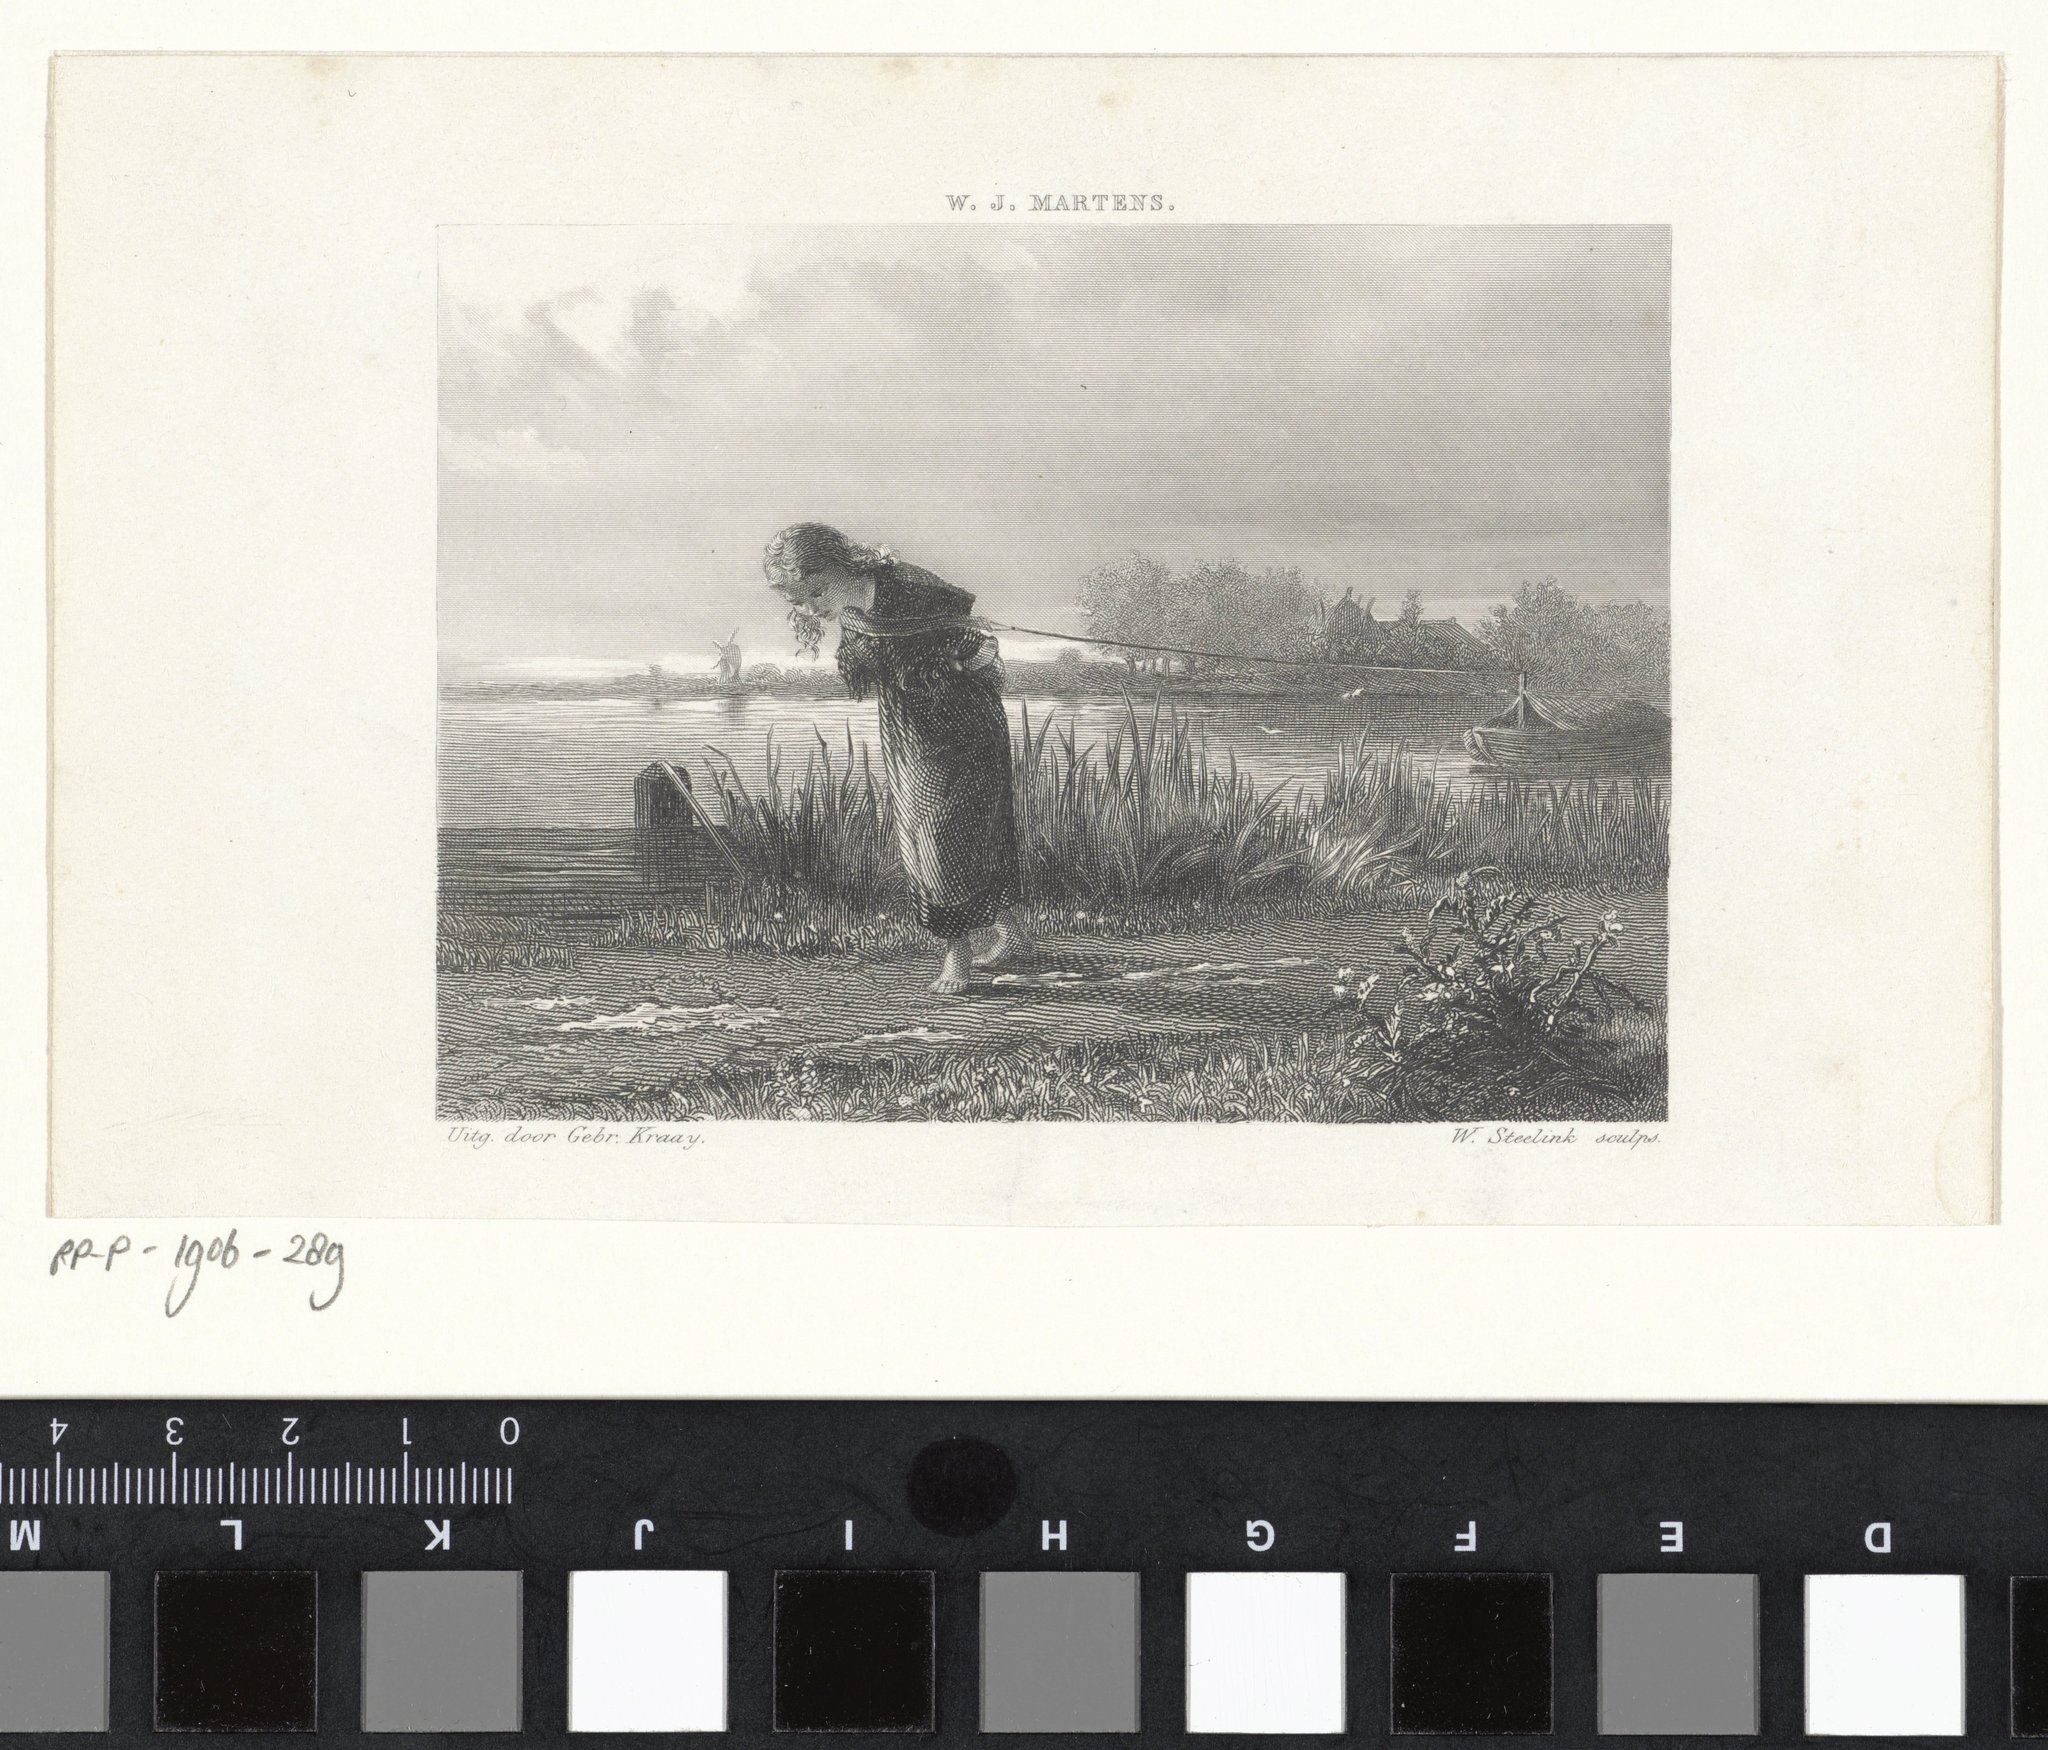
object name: print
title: Meisje trekt een schuit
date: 1867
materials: paper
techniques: etching, engraving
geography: amsterdam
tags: girl (child between toddler and youth), tow-boat, towing-barge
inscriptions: collector's mark: Lugt 2228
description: Illustratie voor: Castalia, jaarboekje aan de fraaie letteren gewijd. Amsterdam: Gebroeders Kraay, 1867.